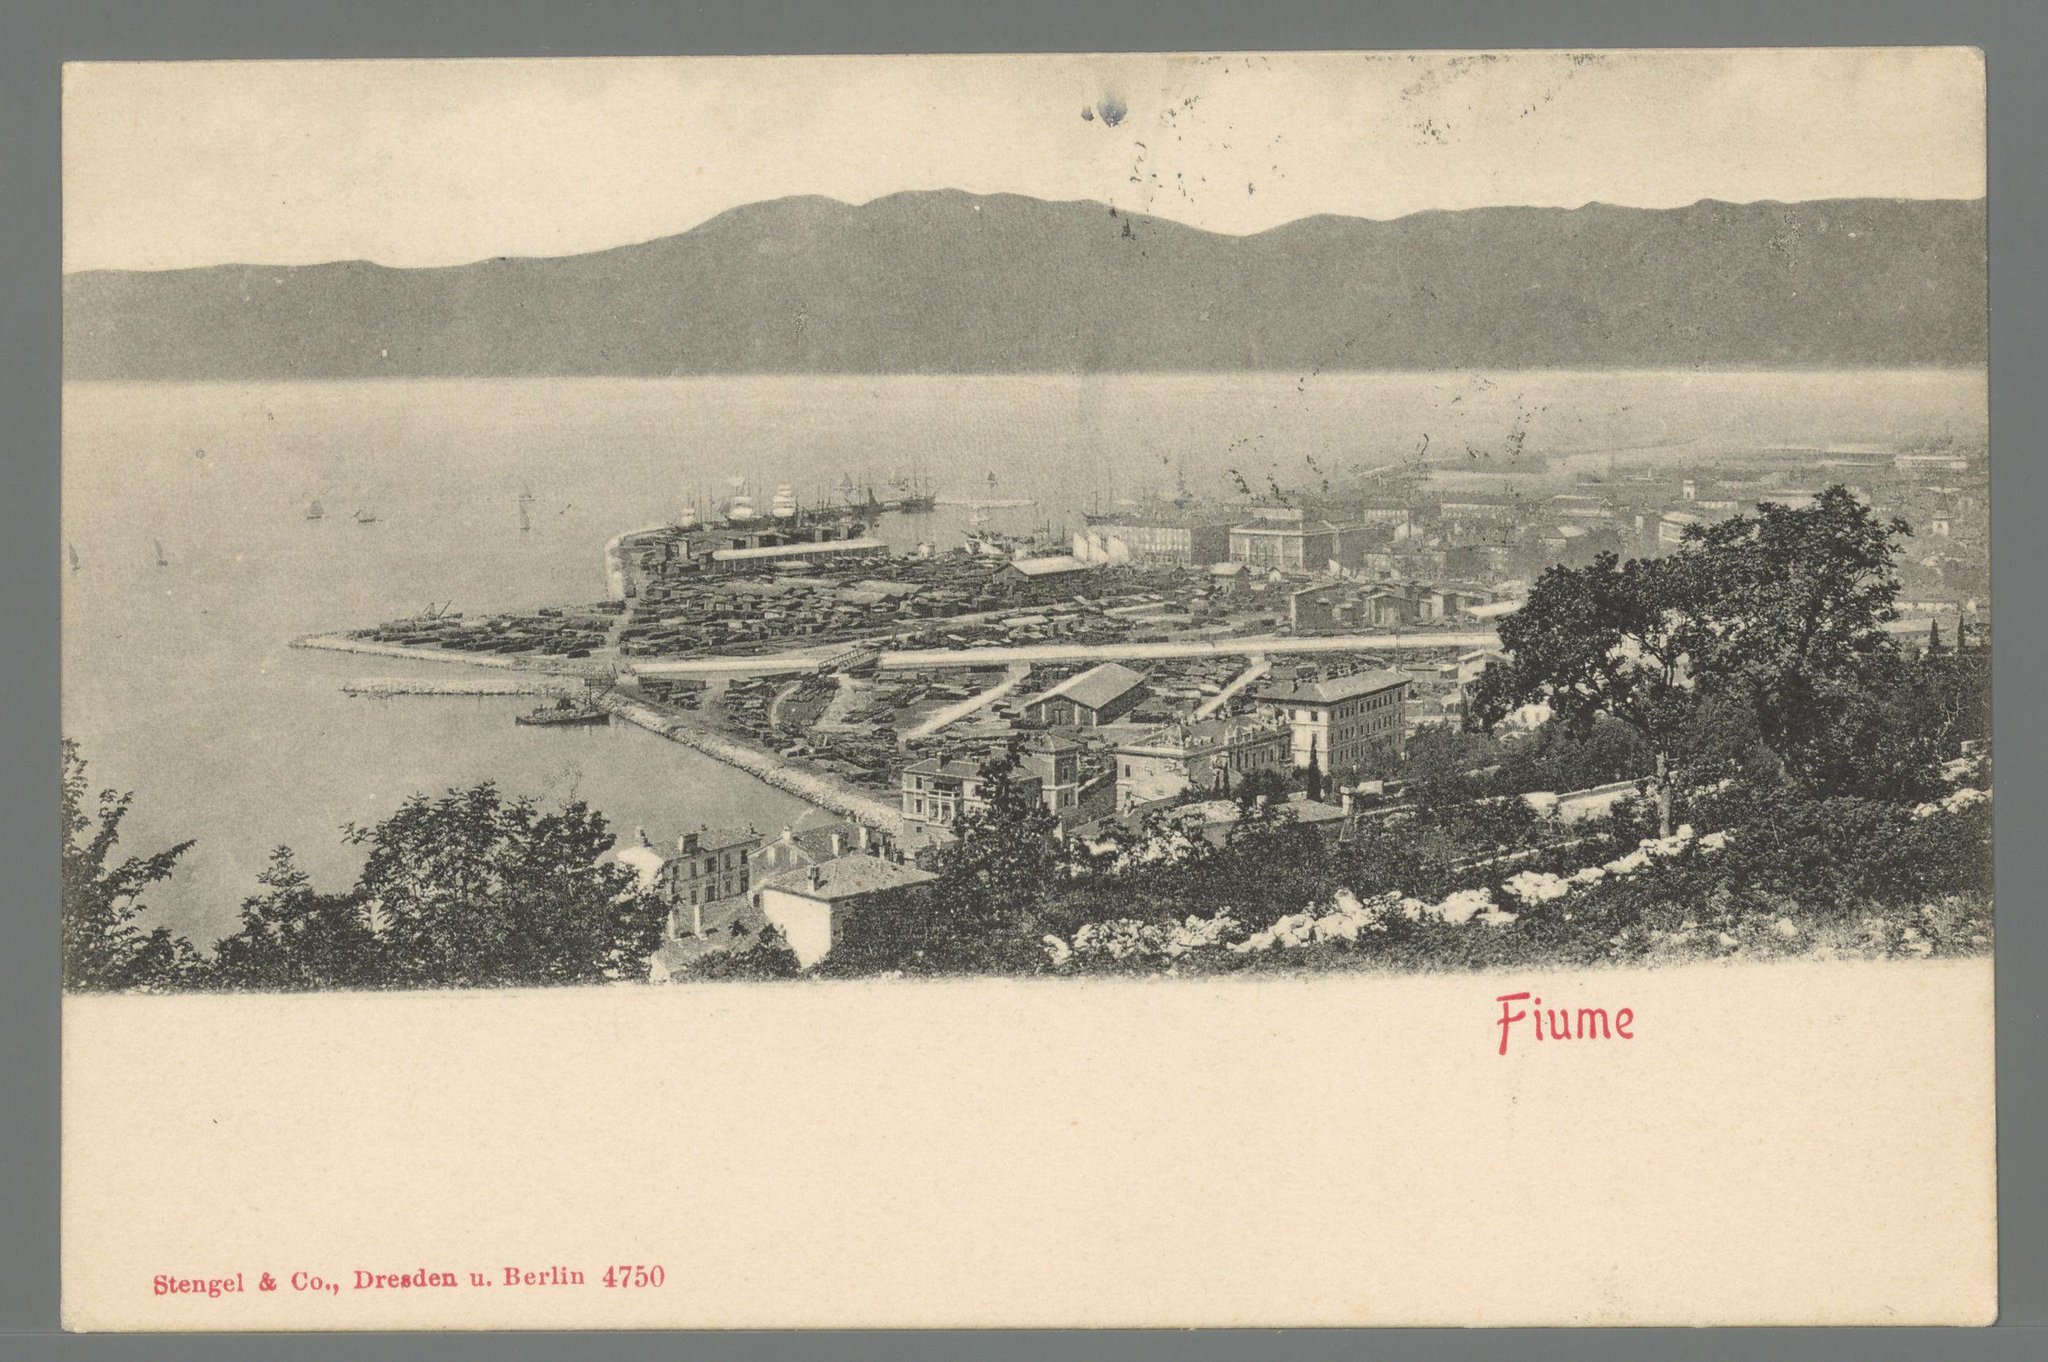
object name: photomechanical print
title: Fiume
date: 1889-1903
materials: cardboard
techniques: photograph, writing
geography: dresden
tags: sea (seascape), prospect of city, town panorama, silhouette of city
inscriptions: postage stamp